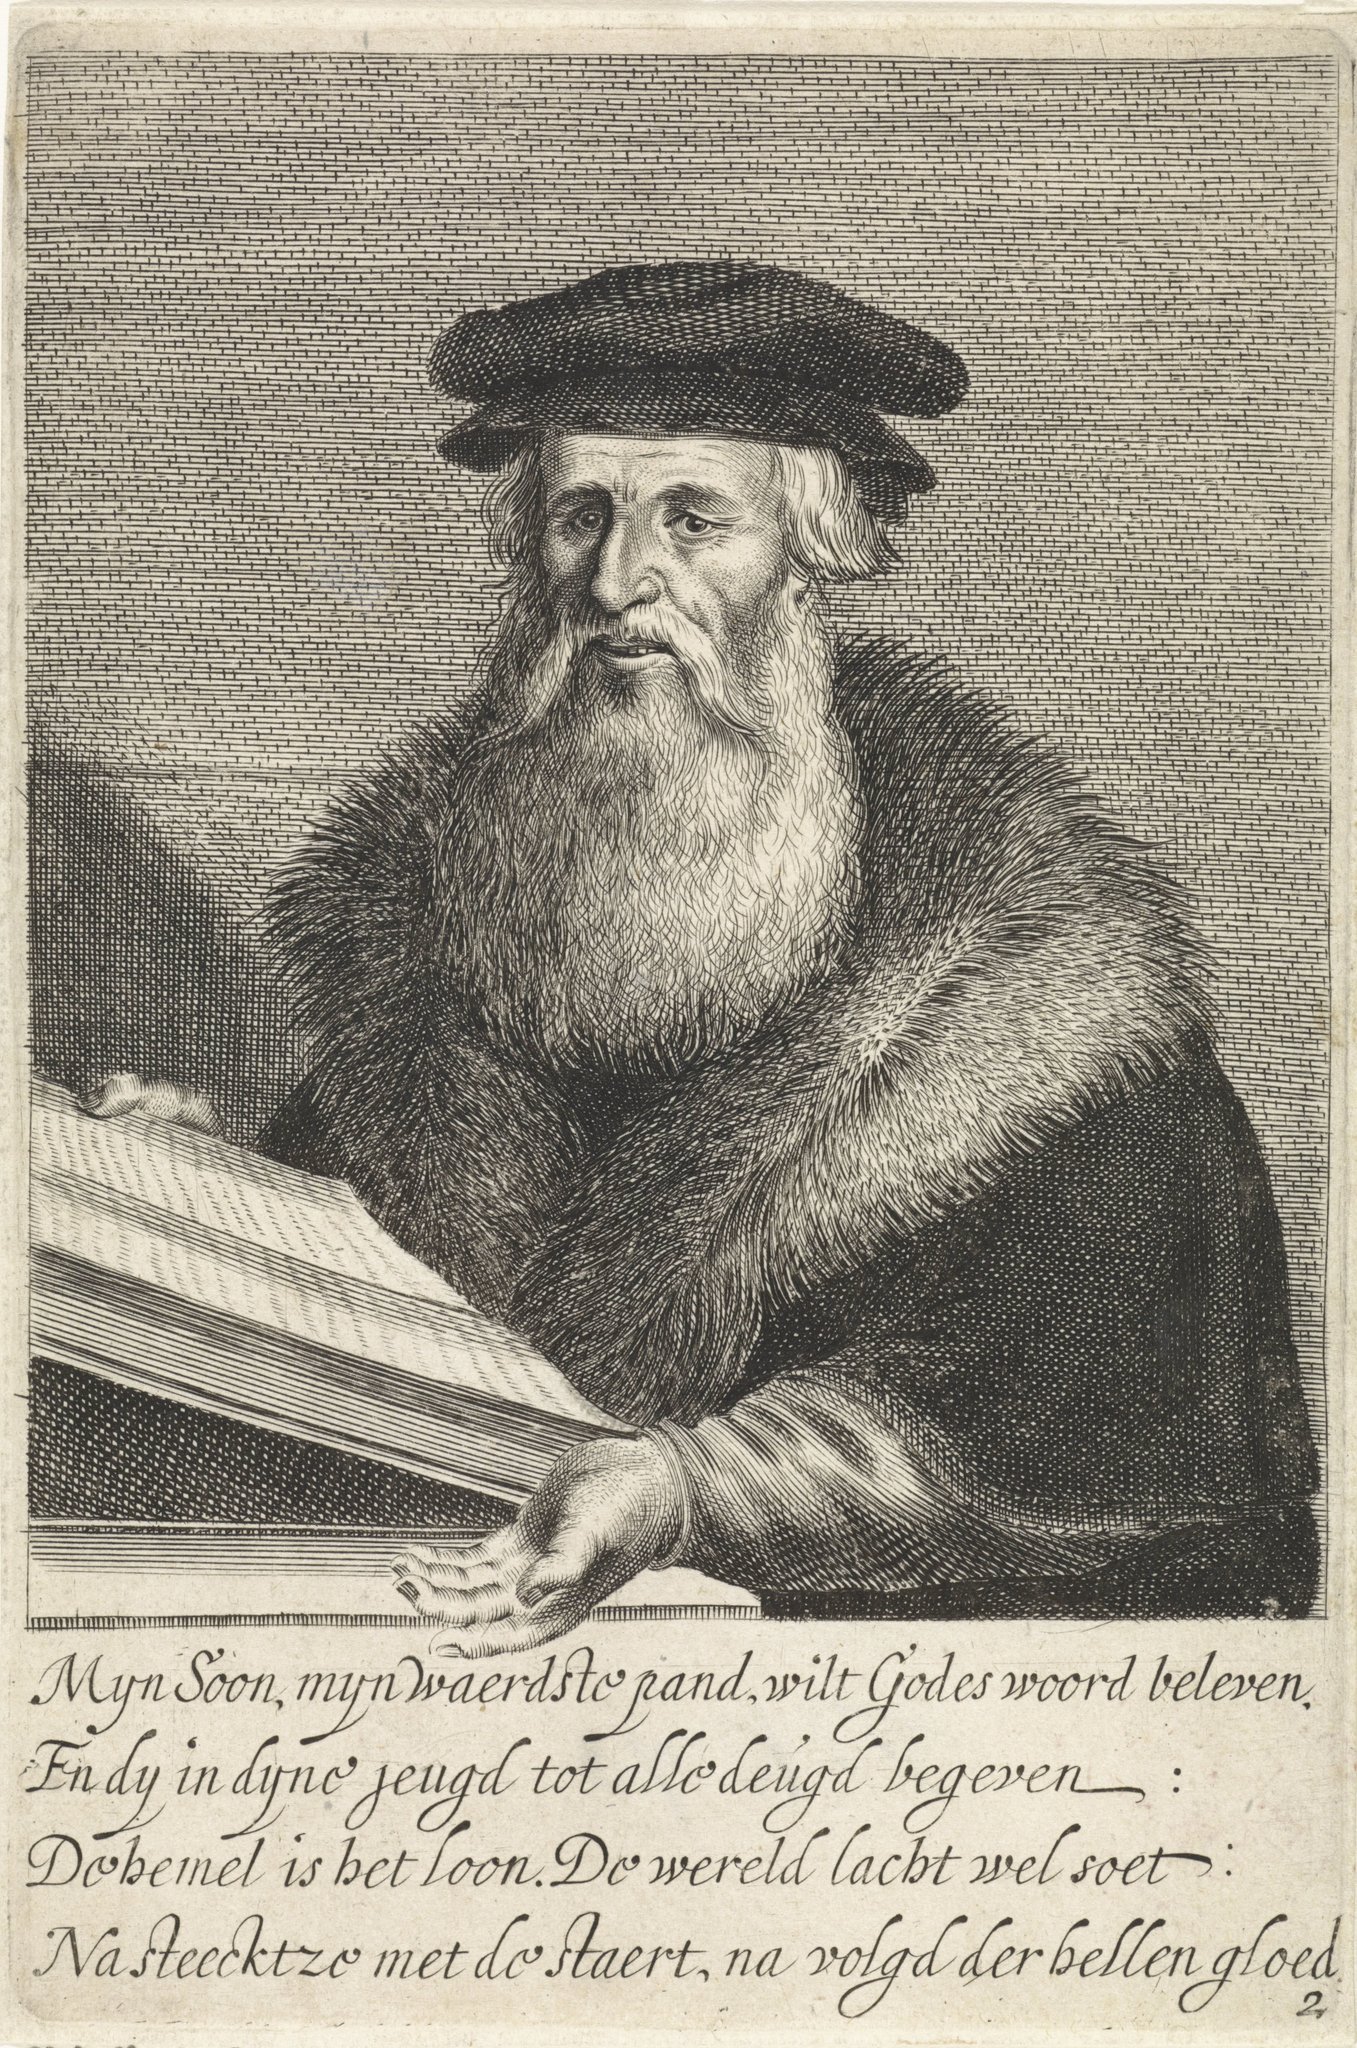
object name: print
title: Spiegel van ijdelheid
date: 1633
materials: paper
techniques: engraving, etching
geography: amsterdam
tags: old man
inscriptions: collector's mark: Lugt 240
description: Een vader spreekt zijn zoon toe, op te passen voor de verlokkingen van het leven. Voor zich een bijbel. Tweede prent van een serie van achttien.